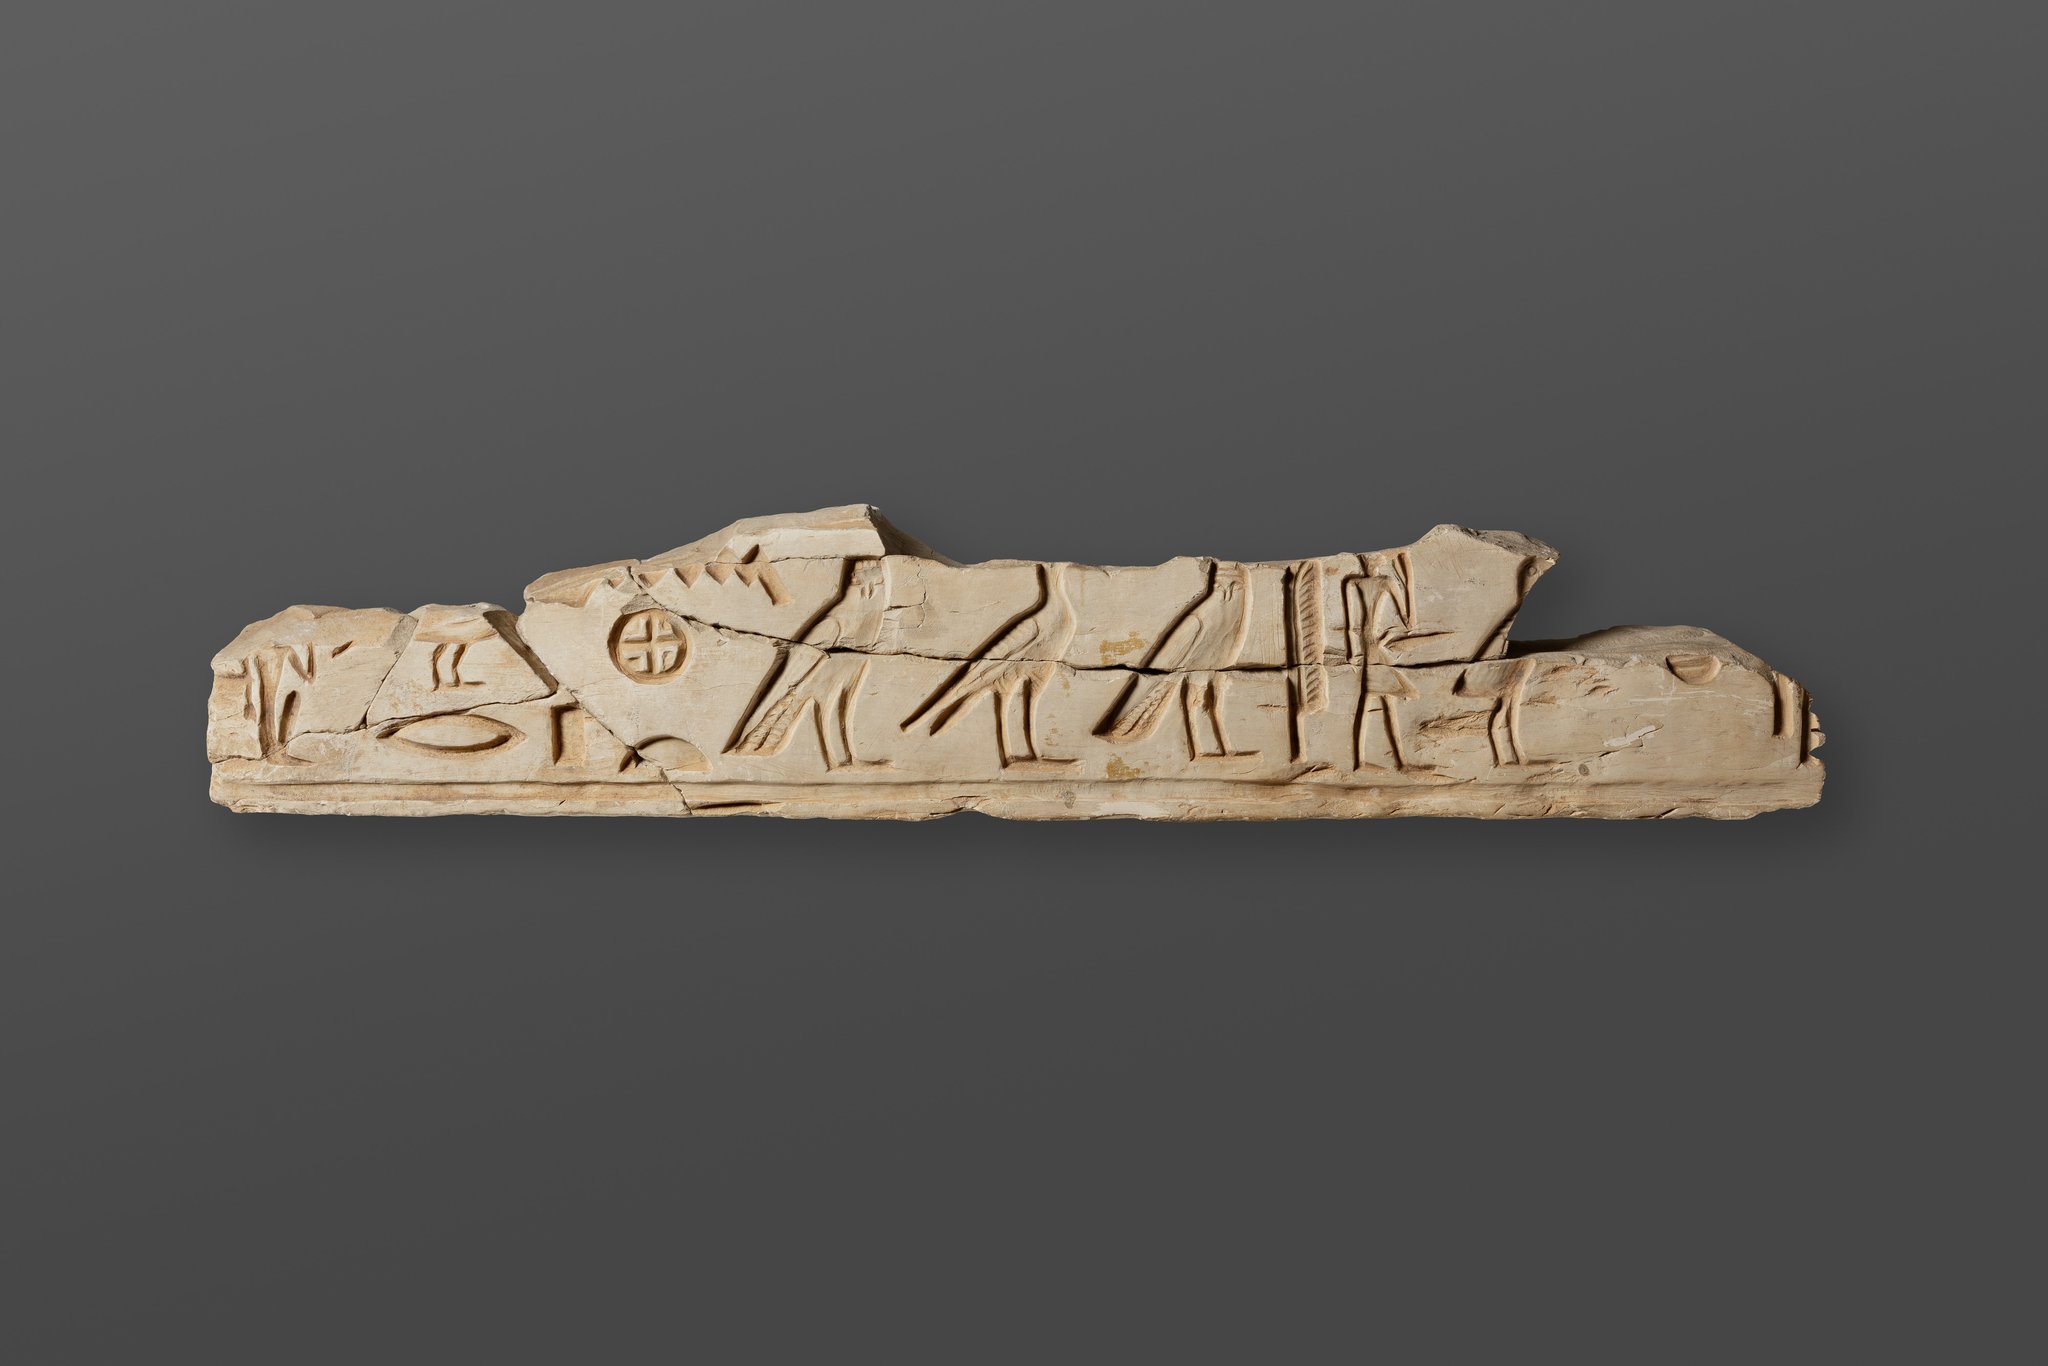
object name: relief fragment, tomb of mereri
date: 2100-2030 BCE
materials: limestone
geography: egypt